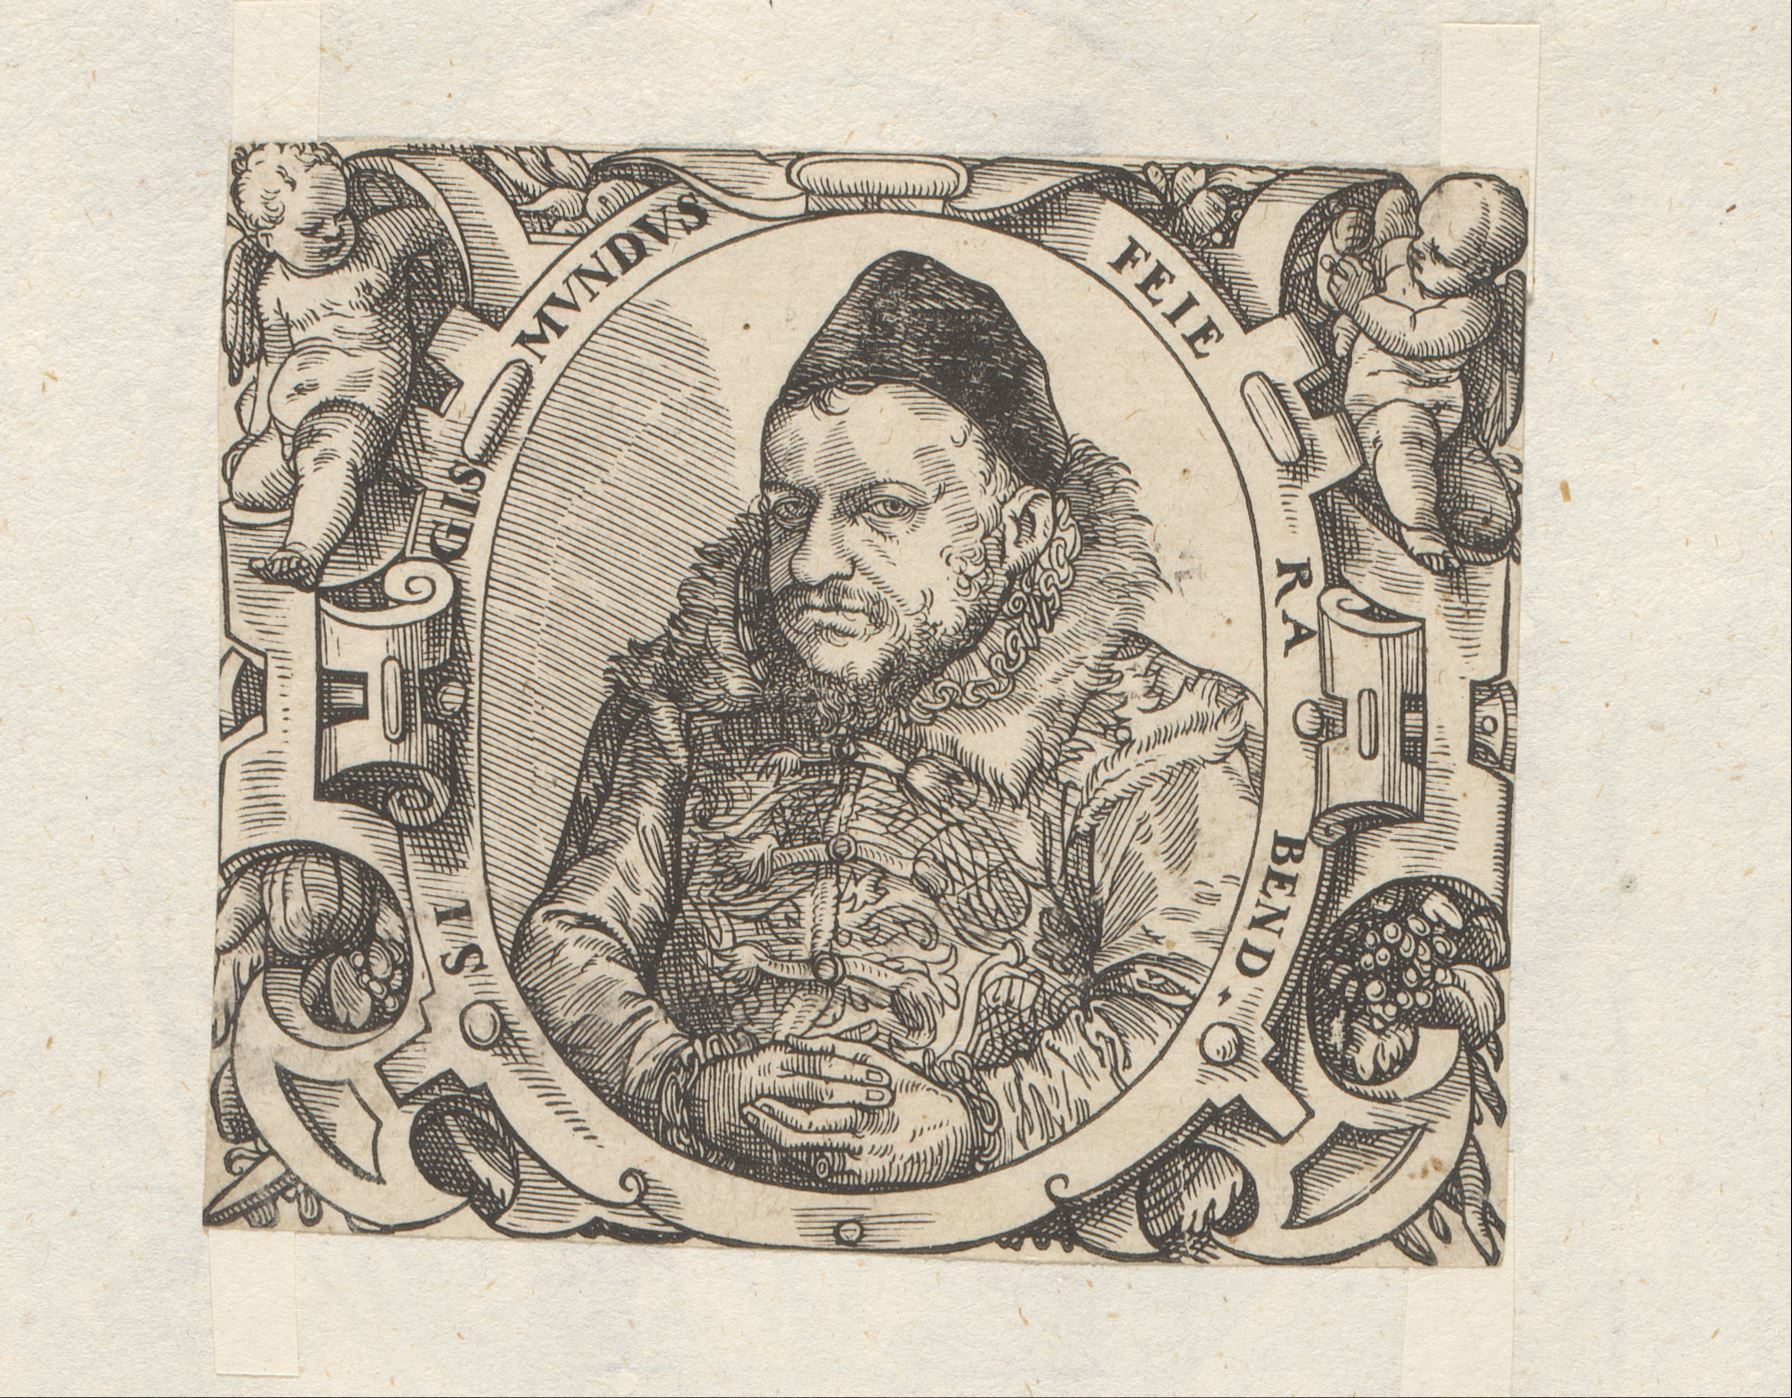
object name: book illustration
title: Portret van Sigmund Feyerabend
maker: Anonymous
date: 1549-1584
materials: paper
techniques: woodcut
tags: print maker, printer, publisher, bookseller, sigmund feyerabend, publishing, publisher (+ portrait of scholar, scientist), historical persons, device (trade-mark of printer or publisher)